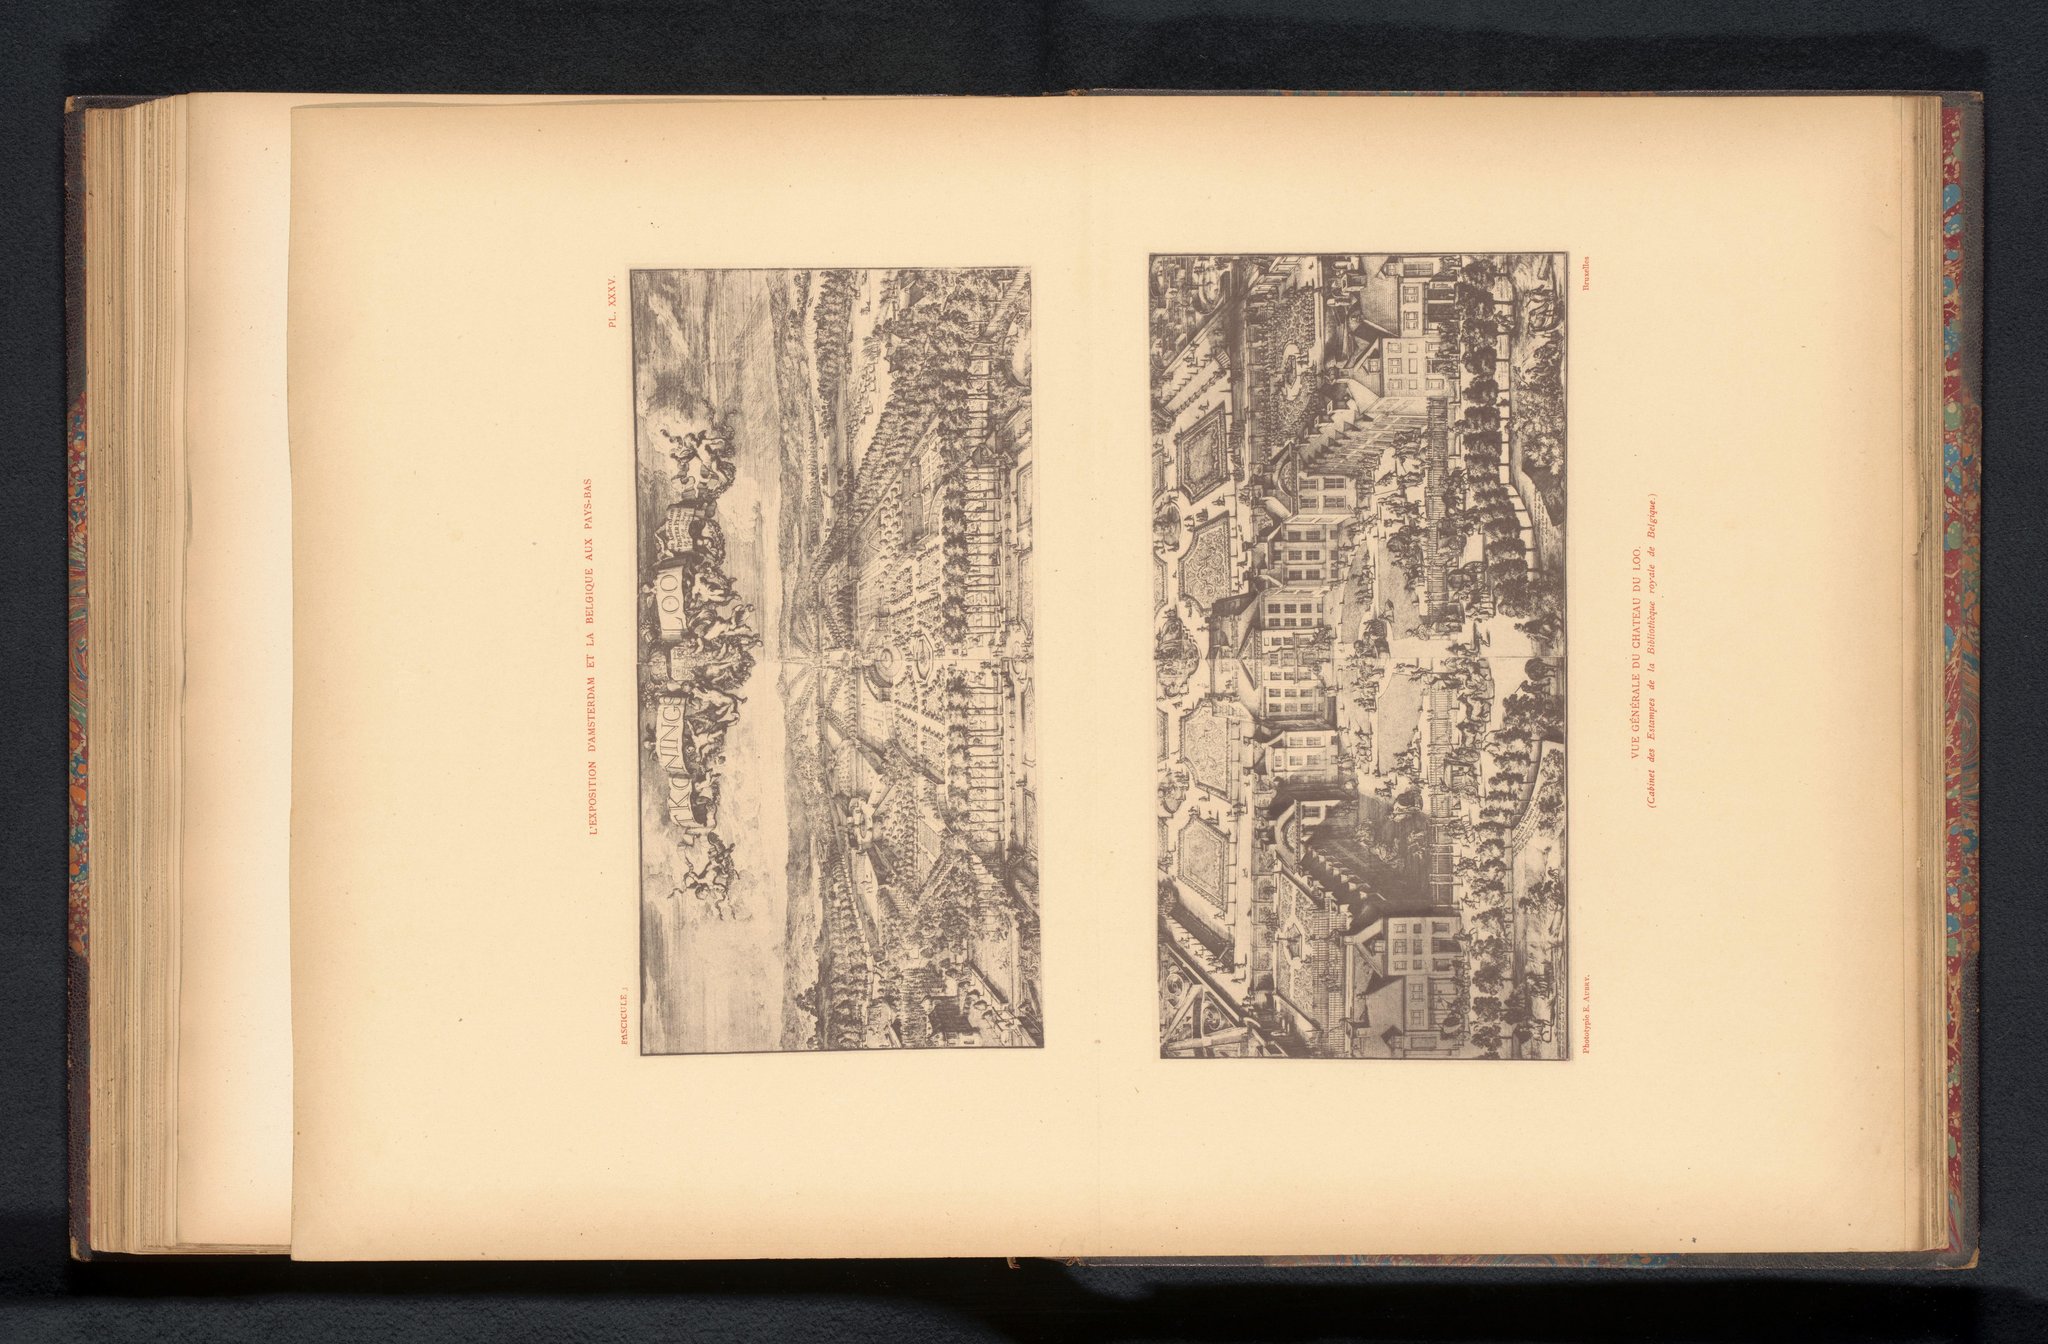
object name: page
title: Reproductie van twee prenten van Paleis Het Loo te Apeldoorn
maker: emile aubry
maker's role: print maker, printer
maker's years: 1829-1900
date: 1878-1883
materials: paper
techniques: photograph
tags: palace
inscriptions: inscription: ‘(Cabinet des Estampes de la Bibliotèque royale de Belgique.)’, inscription: ‘Fascicule 3/ PL. XXXV’